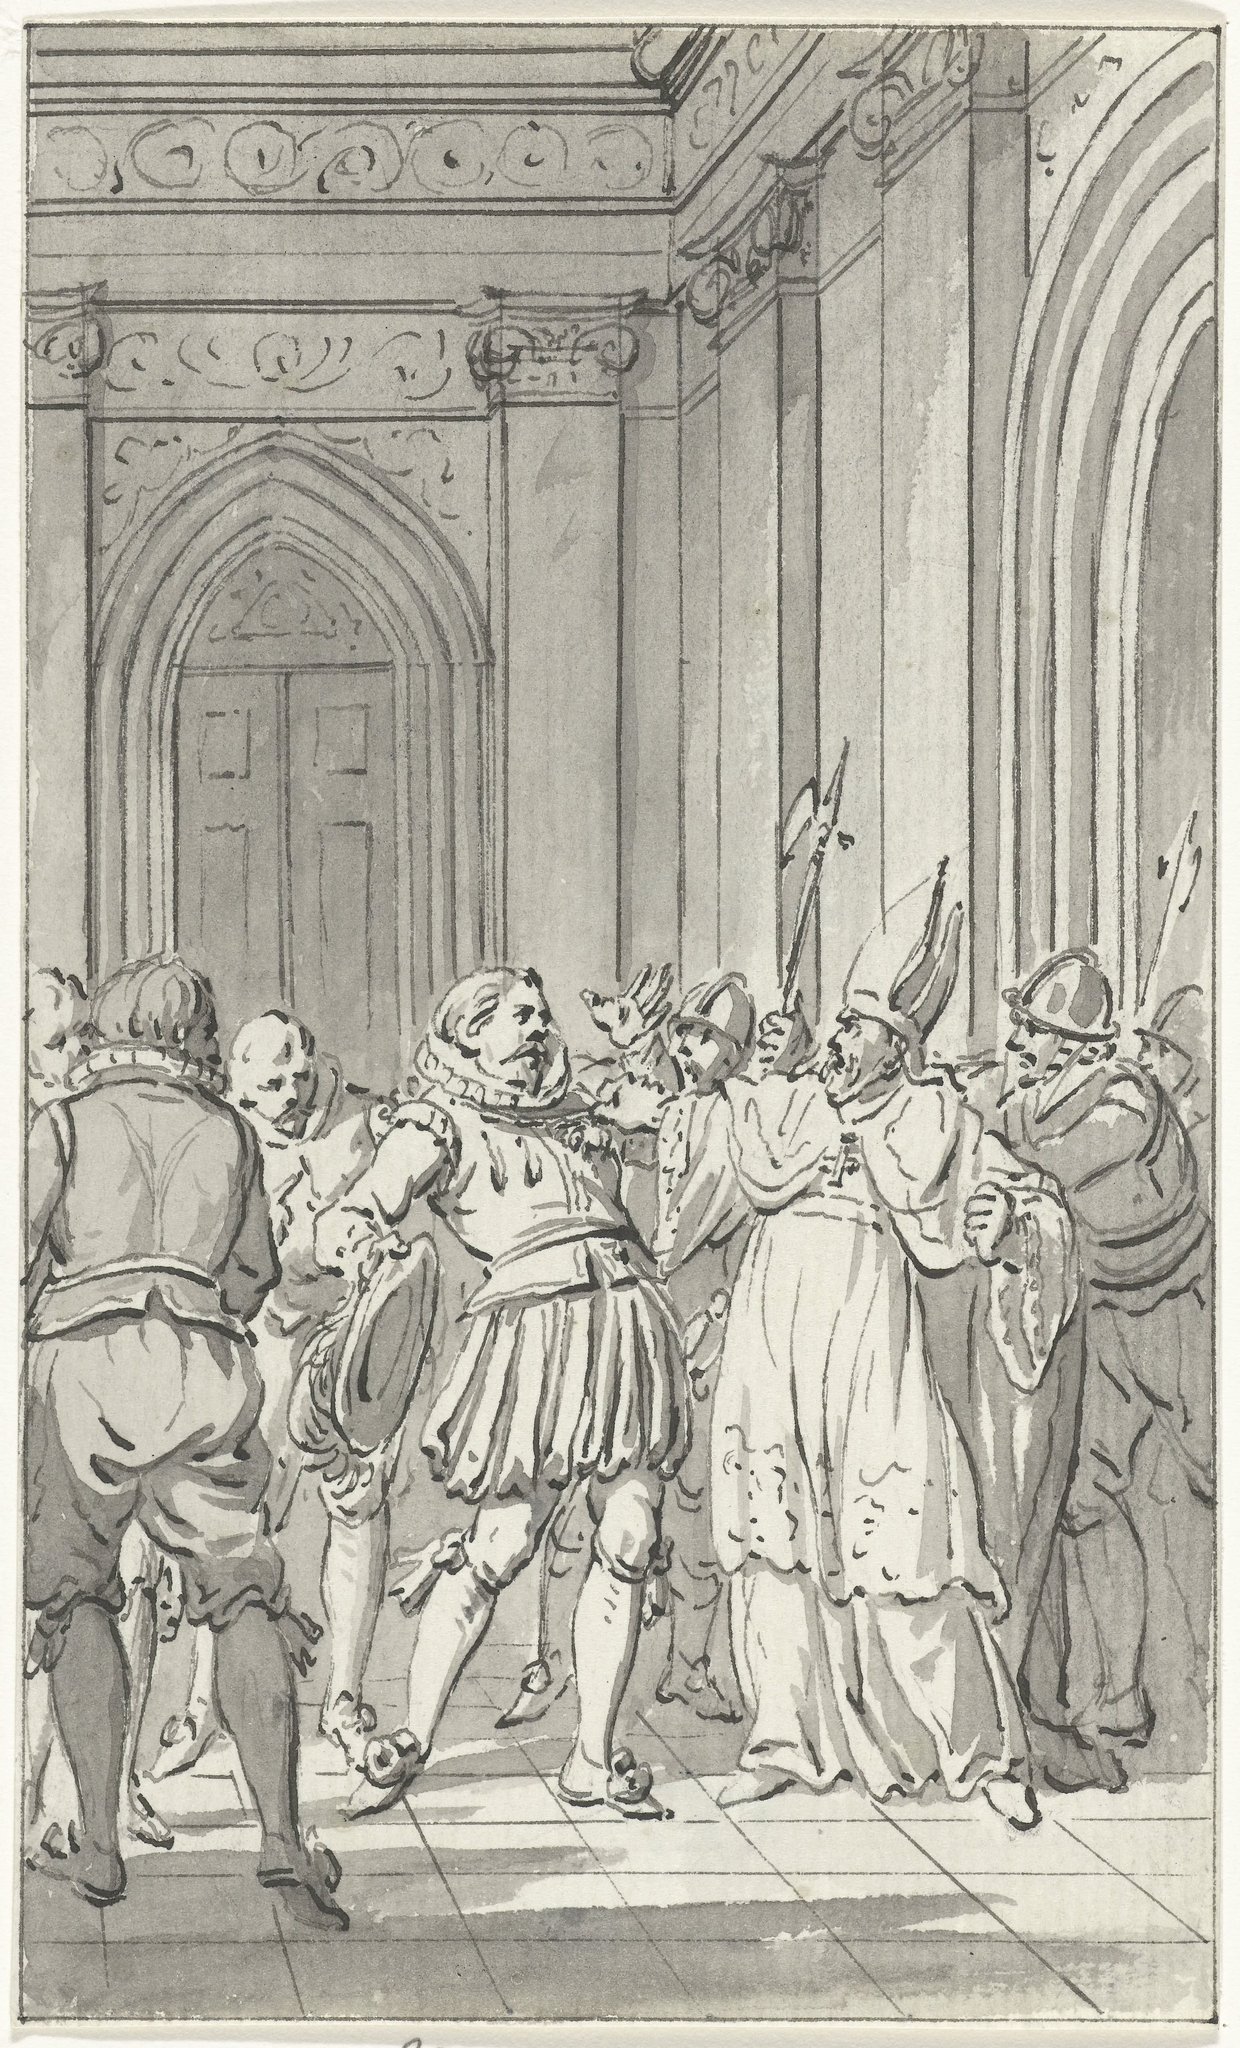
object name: drawing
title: David van Bourgondië, Bisschop van Utrecht, ontneemt Reinoud II van Brederode de versierselen van de orde van het Gulden Vlies, 1470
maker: jacobus buys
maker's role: draughtsman, print maker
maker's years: 1724-1801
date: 1785-1787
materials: ink, paper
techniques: brush, pen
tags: bisschop van utrecht david van bourgondië, charles the bold (duke of burgundy), archbishop, bishop, etc. (roman catholic), historical persons, knighthood order of the golden fleece, historical events and situations, burgundian netherlands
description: Reinoud II van Brederode, wordt door de bisschop van Utrecht David van Bourgondië de ridderorde van het Gulden Vlies afgerukt, wegens de (valse) beschuldiging dat hij een aanslag op het leven van Karel de Stoute beraamd zou hebben, 1470. Ontwerp voor een prent.